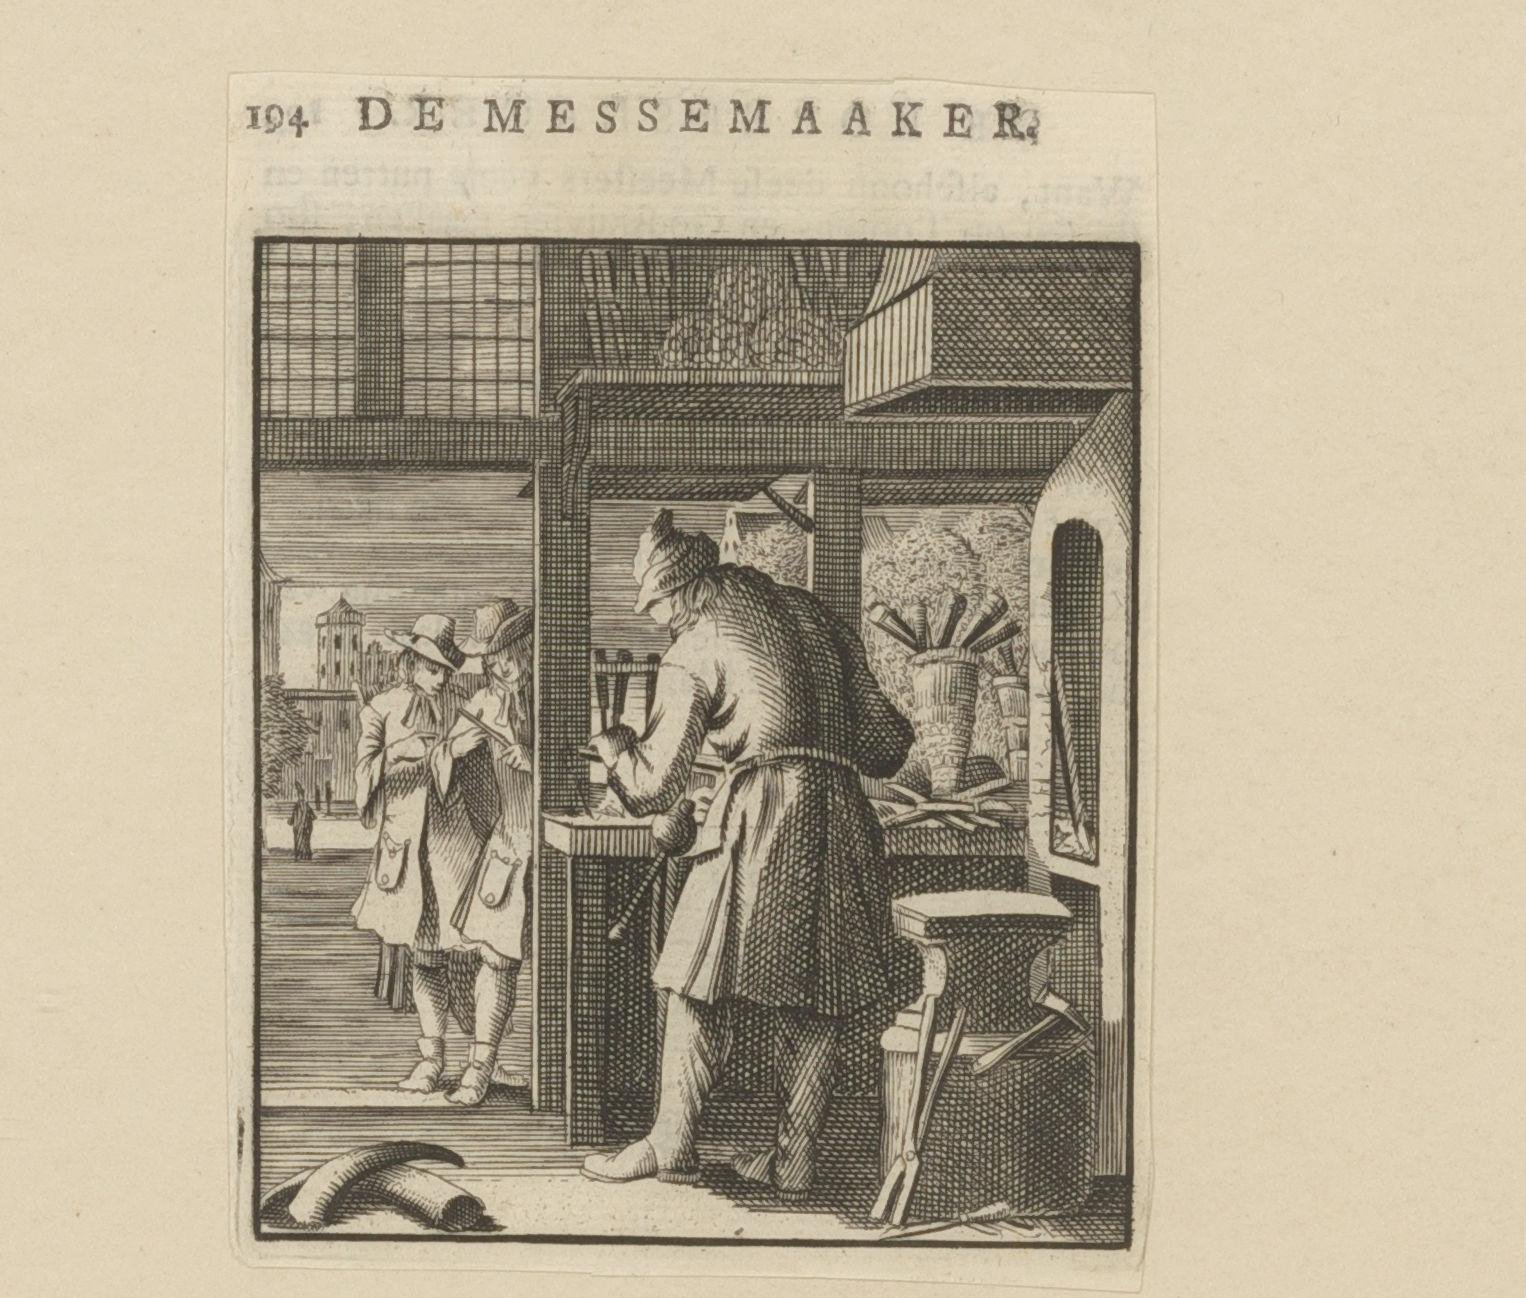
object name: print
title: De Messemaaker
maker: Anonymous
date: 1719-1759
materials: paper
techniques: etching, letterpress printing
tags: handicrafts, craftsman at work, tools, aids, implements ~ crafts and industries: knife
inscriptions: stamp, collector's mark: Lugt 1641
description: Prent met andere letterzetting gebruikt in: St. Clara, Abraham van. Iets voor allen. [Vertaald door] J. le Long. Amsterdam: Janssoons van Waesberge, 1719, dl. 2. En in: St. Clara, Abraham van. Iets voor allen. [Vertaald door] J. le Long. Amsterdam: Jan Roman de Jonge, 1741, dl. 2. En in: St. Clara, Abraham van. Iets voor allen. [Vertaald door] J. le Long. Amsterdam: Jan Roman, 1759, dl. 2. Huidige prent uit een andere editie. Naar een prent van: Jan Luyken.